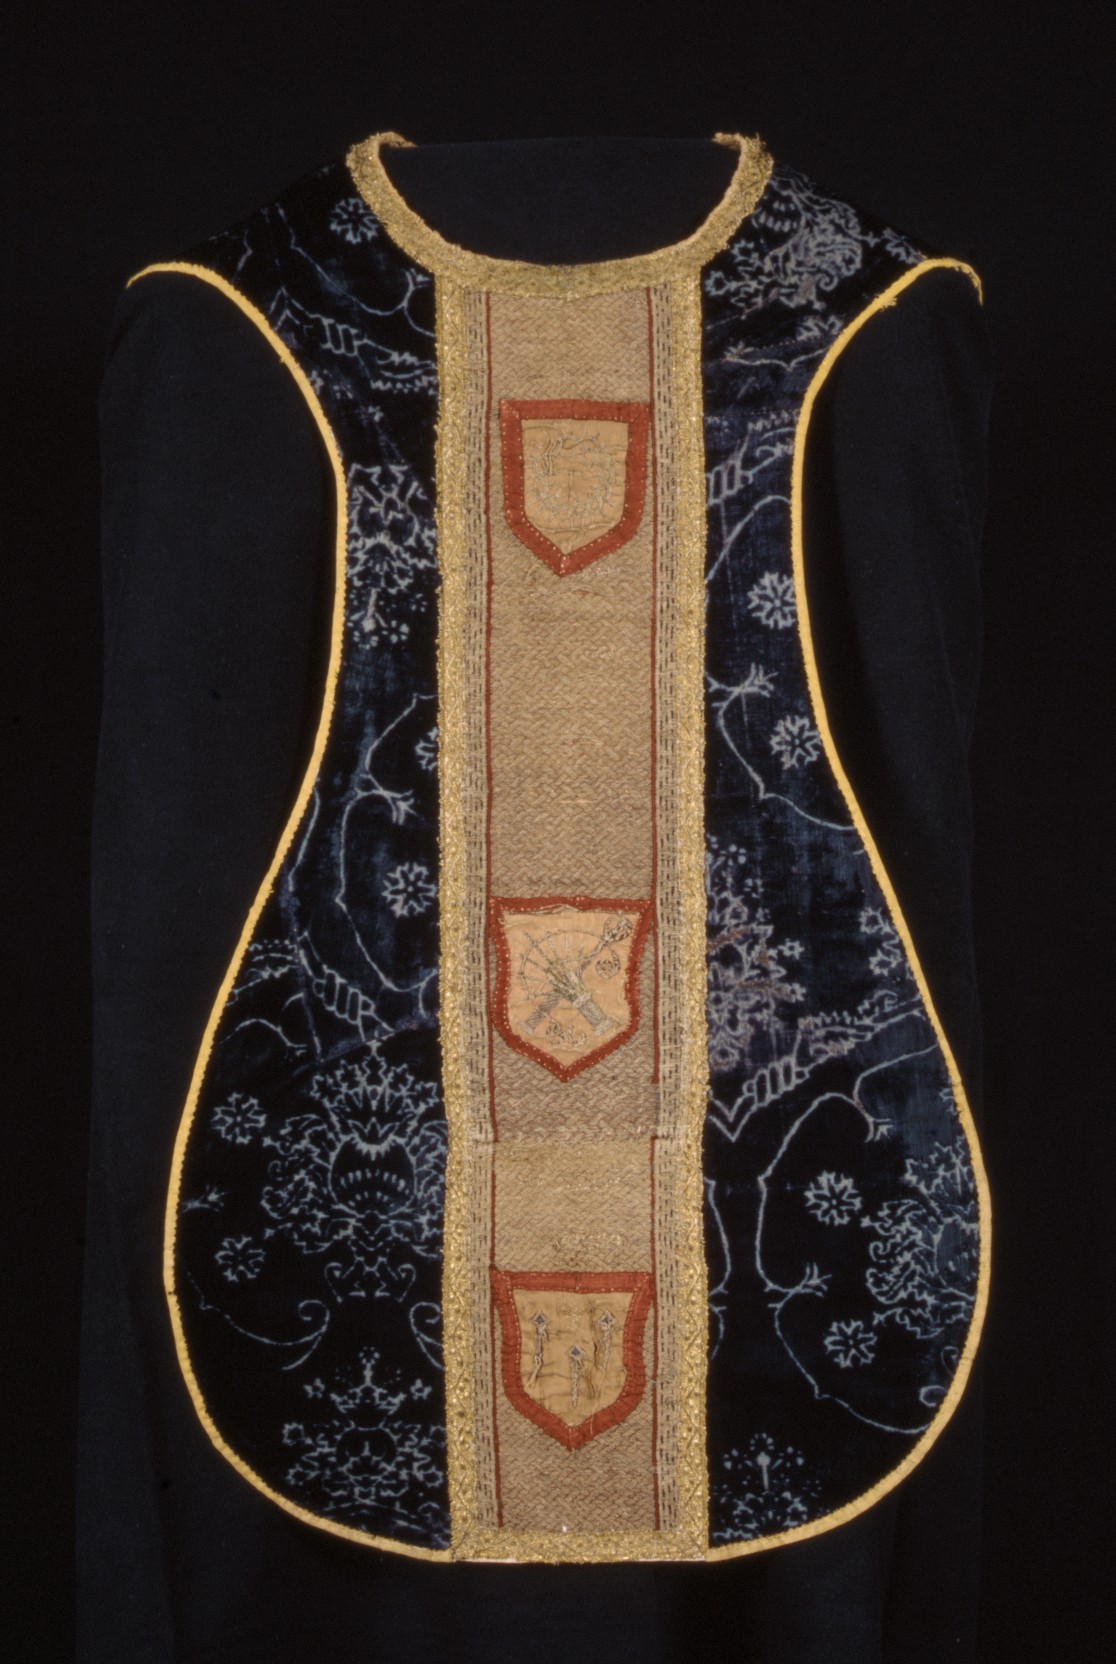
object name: chasuble with orphrey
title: Chasuble with an Orphrey Band and Cross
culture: german or italian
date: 1451-1500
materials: linen, metal, silk